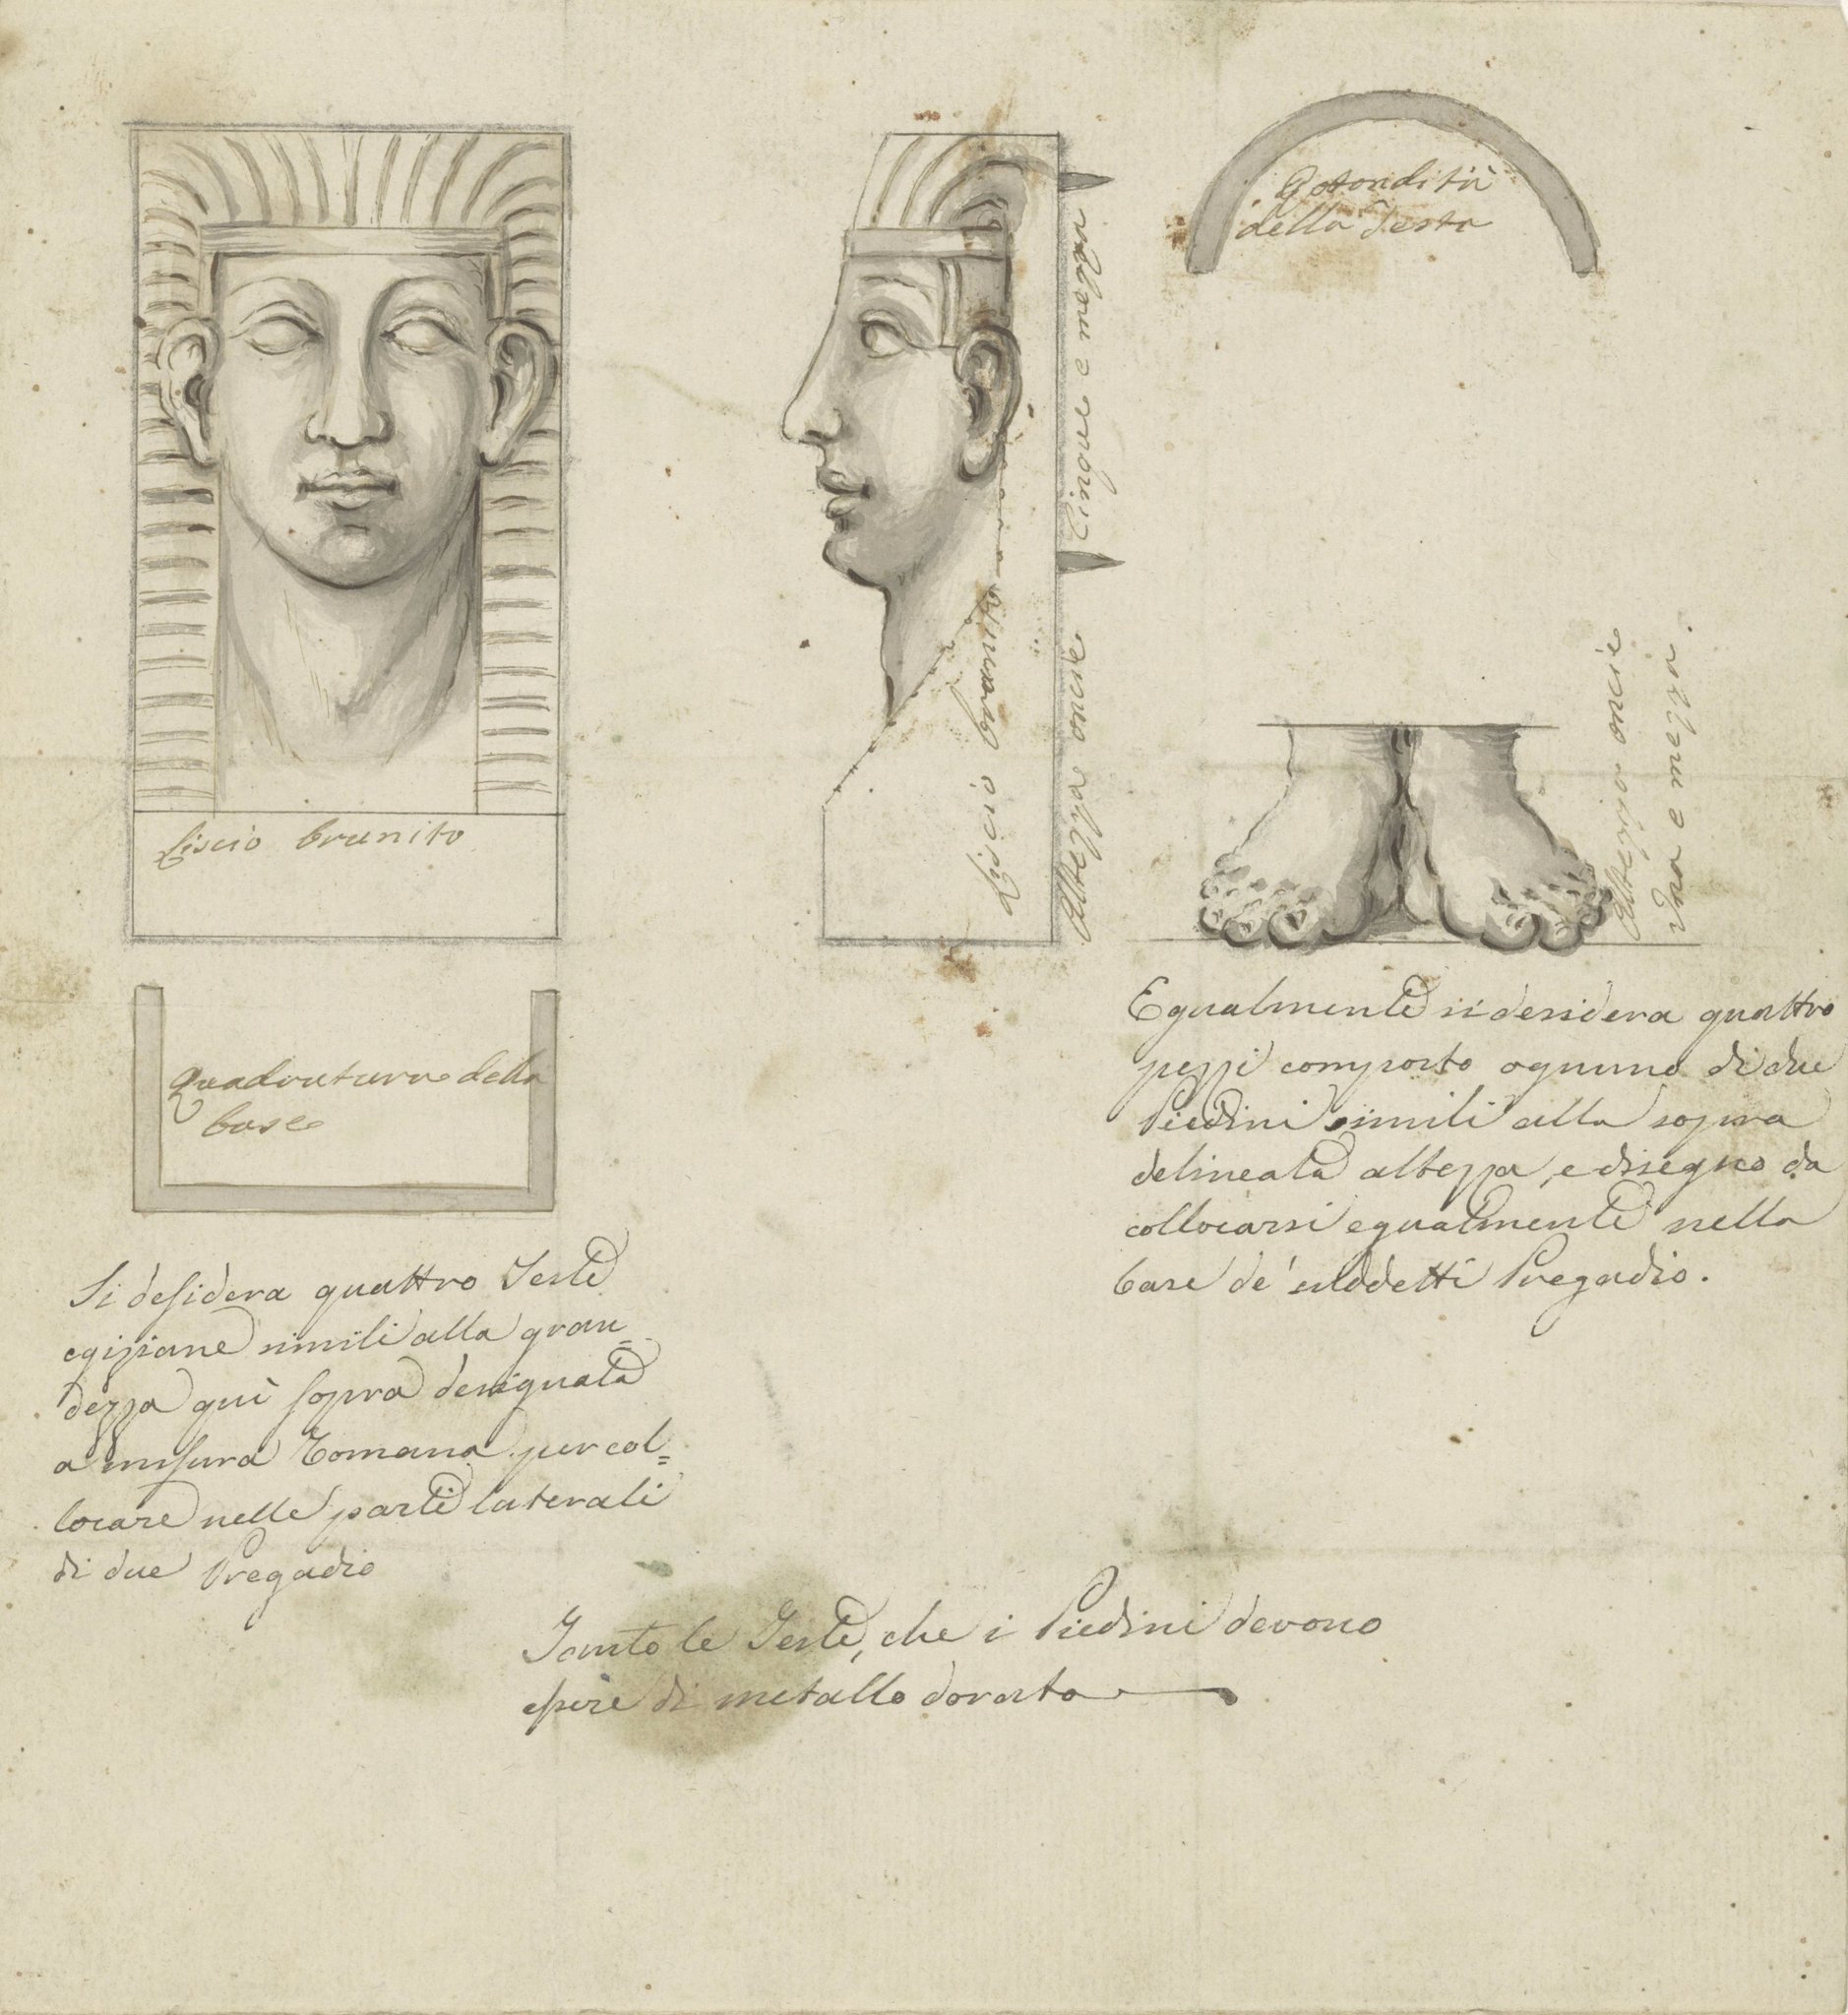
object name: design drawing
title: Ontwerp voor meubelbeslag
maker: giuseppe valadier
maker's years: 1762-1839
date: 1800-1820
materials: chalk, paper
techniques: brush, pen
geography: rome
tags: decorative furniture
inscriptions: inscription: ‘liscio brunito / quadratura della base / Si desidera quattro Testi egiziane simili alla grandezza qui sopra designata a misura romana per collocare nelle parti laterali di due Pregadie / Liscio brunito / Altezza onciè Cinque e mezza / Rotondità della Testa / Altezza onciè Una e mezza / Egualmente si desidera quattro pezzi comporto ognuno di due Piedini simili alla sopra delineata altezza, e disegno da collocarsi egualmente nella base dei suddetti Pregadio. / Tanto le Teste, che i Piedini devono essere di metallo dorato.’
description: Ontwerp voor meubelbeslag in de vorm van een Egyptisch hoofd en een paar voeten.